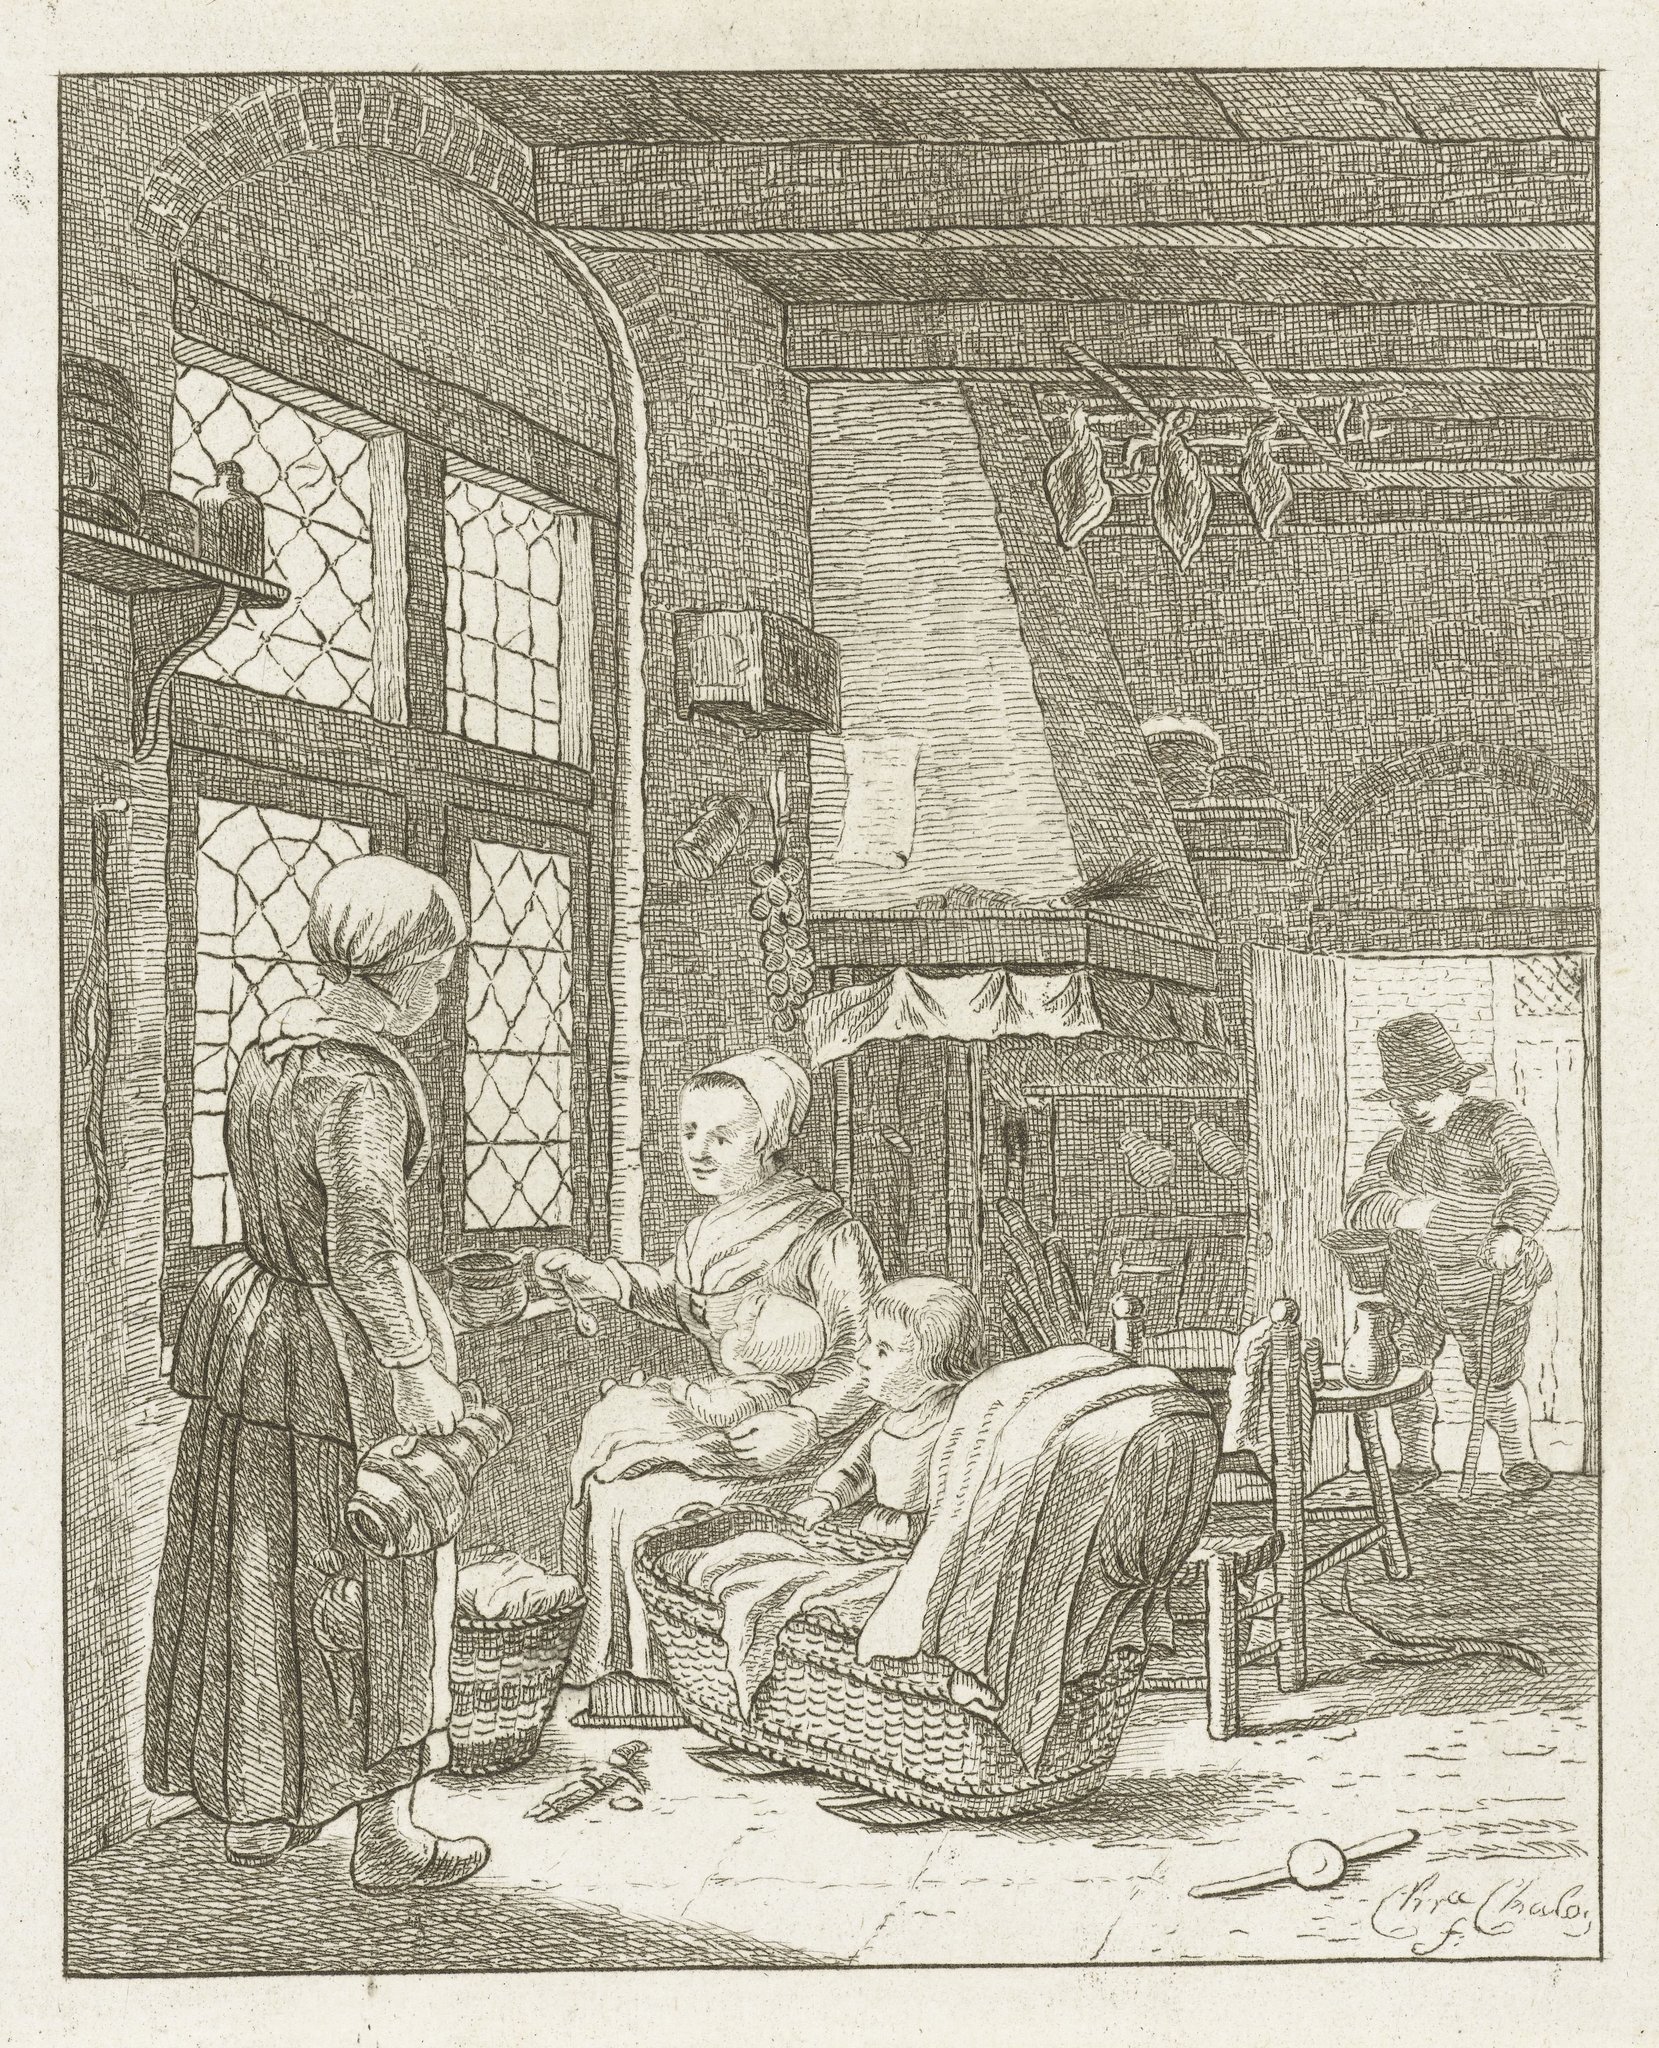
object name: print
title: Thuiskomst van vader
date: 1779-1796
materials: paper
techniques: etching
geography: leiden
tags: kitchen-interior, feeding a baby, cradle, crib, kitchen-maid, kitchen servant, mother and child(ren), woman and child(ren) (family group) (with number of children), father (first degree family relationships)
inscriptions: collector's mark: Lugt 2233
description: Interieur van een keuken. Op de voorgrond een moeder met haar twee kinderen. Ze geeft juist de baby een lepel pap. Haar zoontje staat naast de wieg. Een meid komt een kruik aanbrengen. Op de achtergrond komt de vader van het gezin door de deur gestapt.